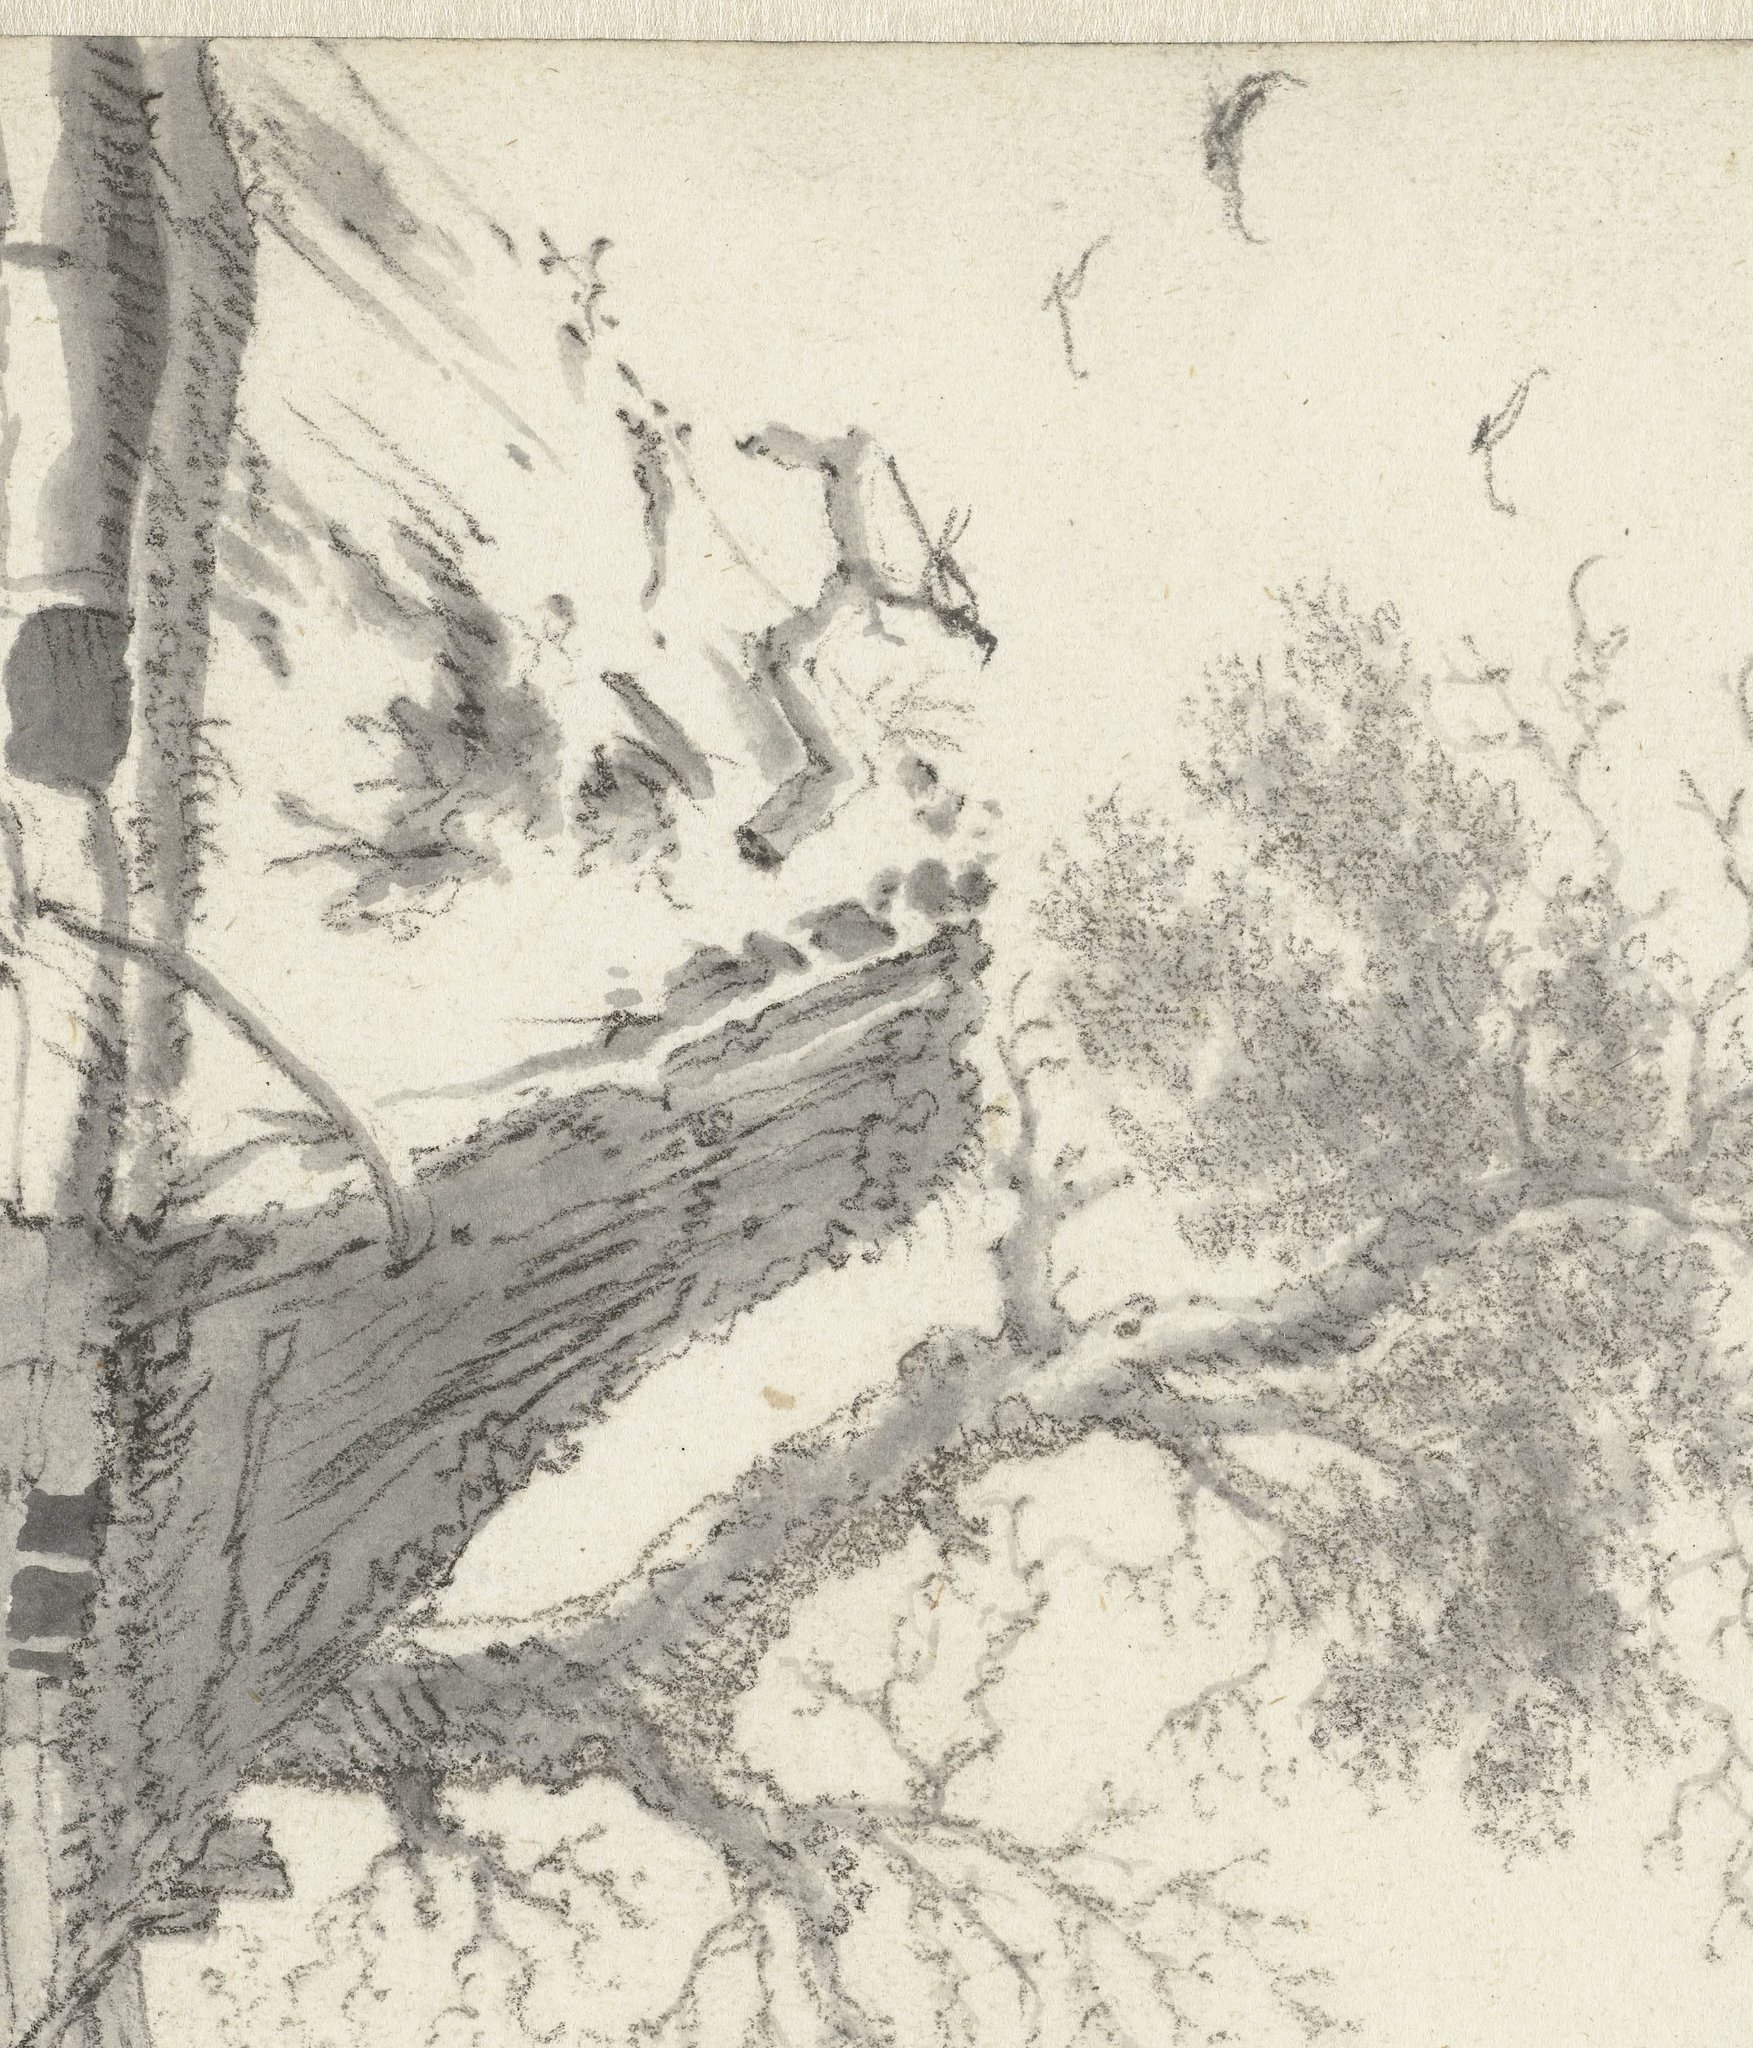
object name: drawing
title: Country Cottage along the Water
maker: cornelis saftleven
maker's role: draughtsman, painter, print maker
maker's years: 1607-1681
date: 1617-1681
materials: chalk, ink, paper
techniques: brush, drawing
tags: farm (building)